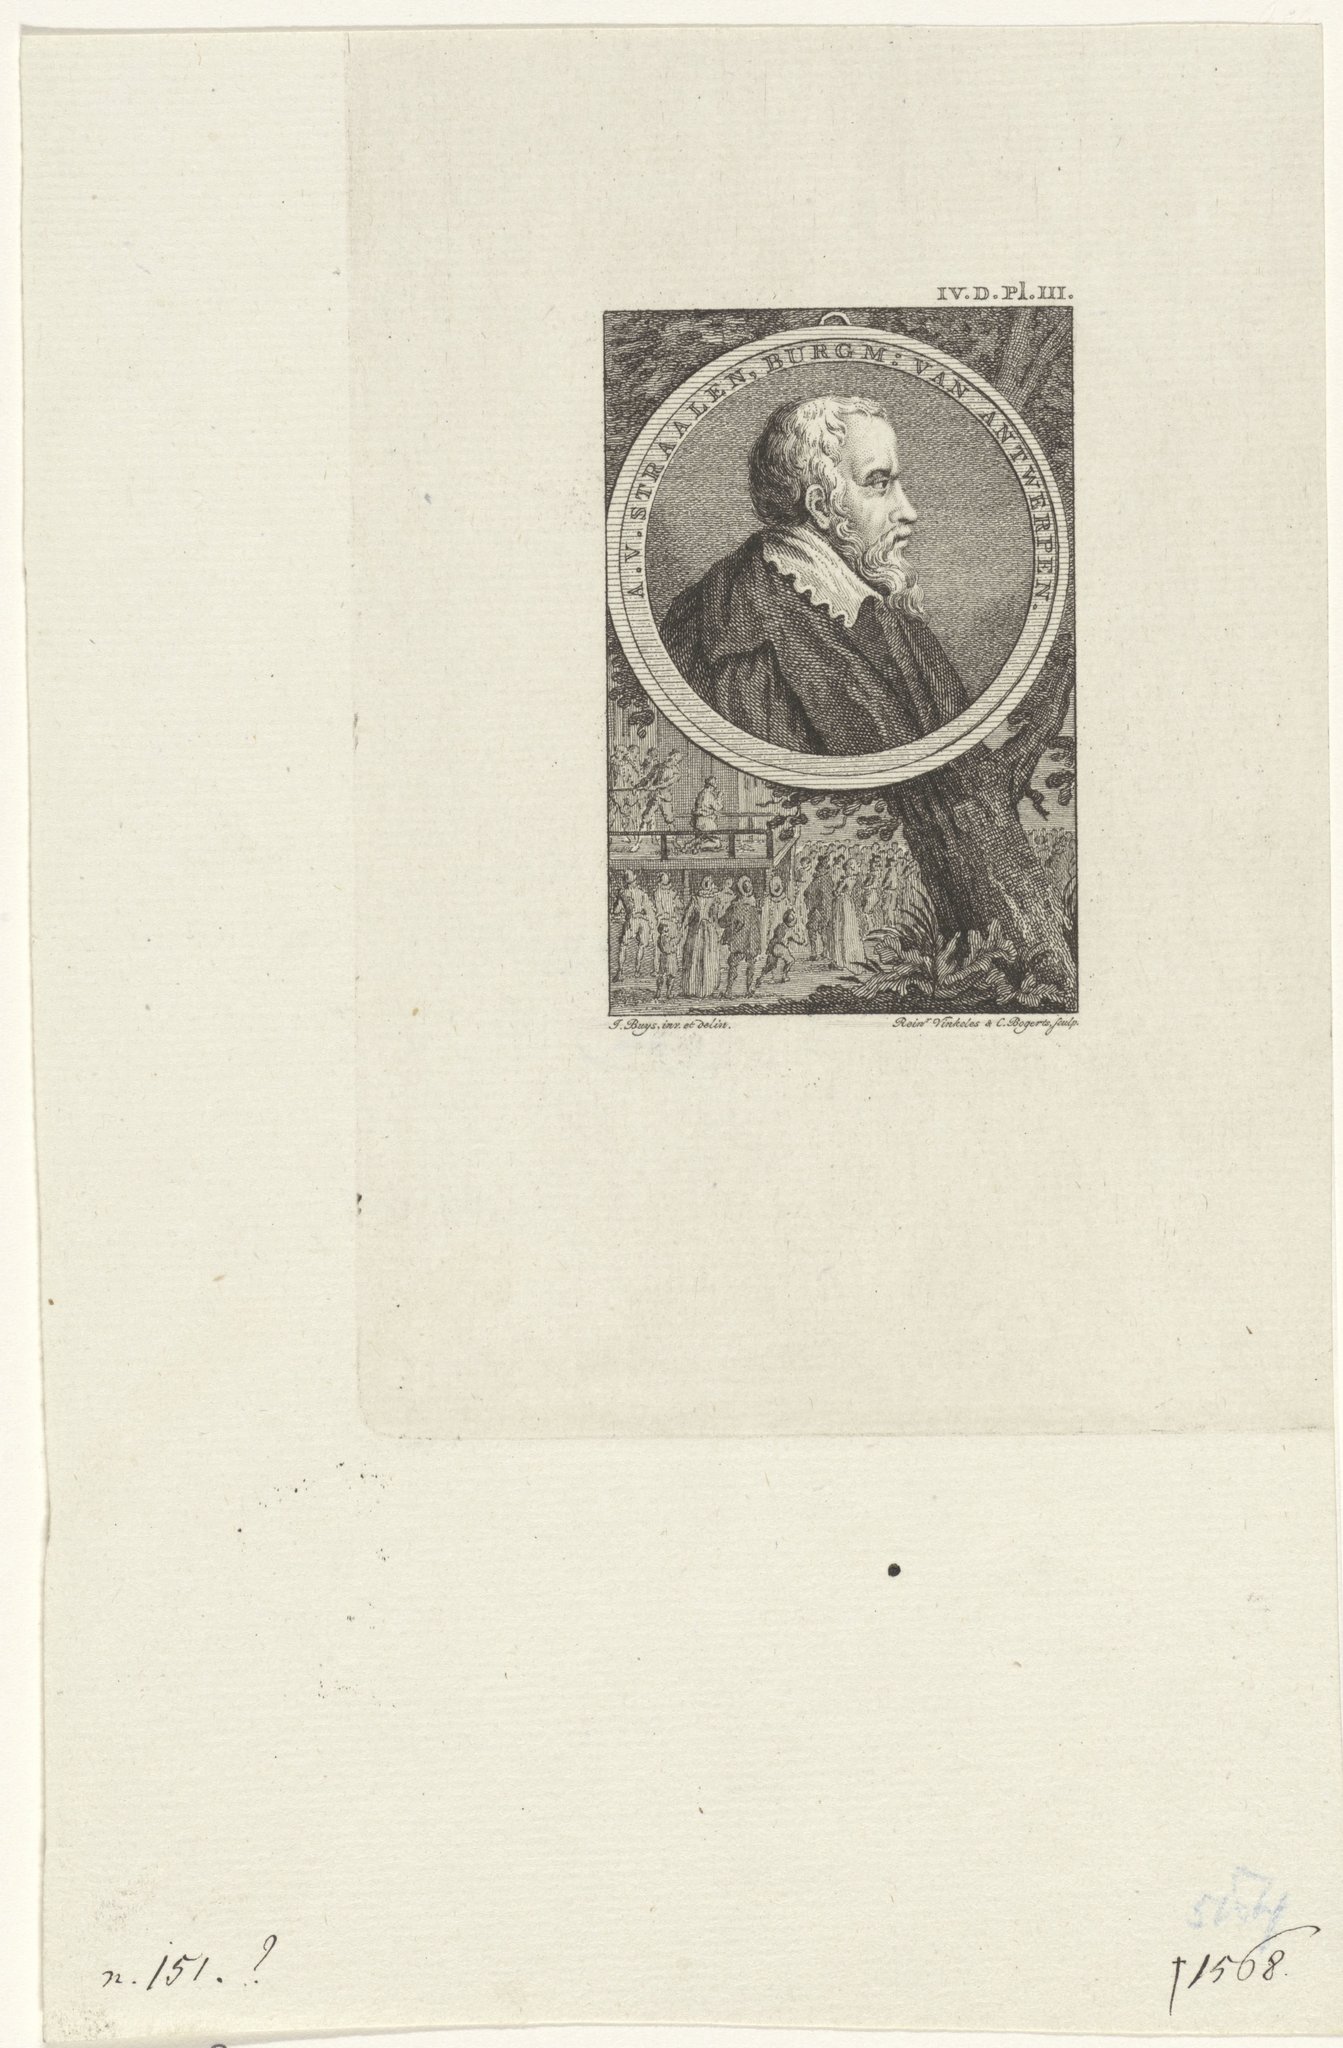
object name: print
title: Portret van Antoon van Straalen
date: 1783-1795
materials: paper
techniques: engraving, etching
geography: amsterdam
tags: antwerp, on the scaffold or place of execution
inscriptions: collector's mark: Lugt 2228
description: Prent gebruikt in: Fokke, Jan. Geschiedenissen der Vereenigde Nederlanden voor de vaderlandsche jeugd Ie-XXVste deel. Amsterdam: Johannes Allart, 1783-1795. Deel IV.